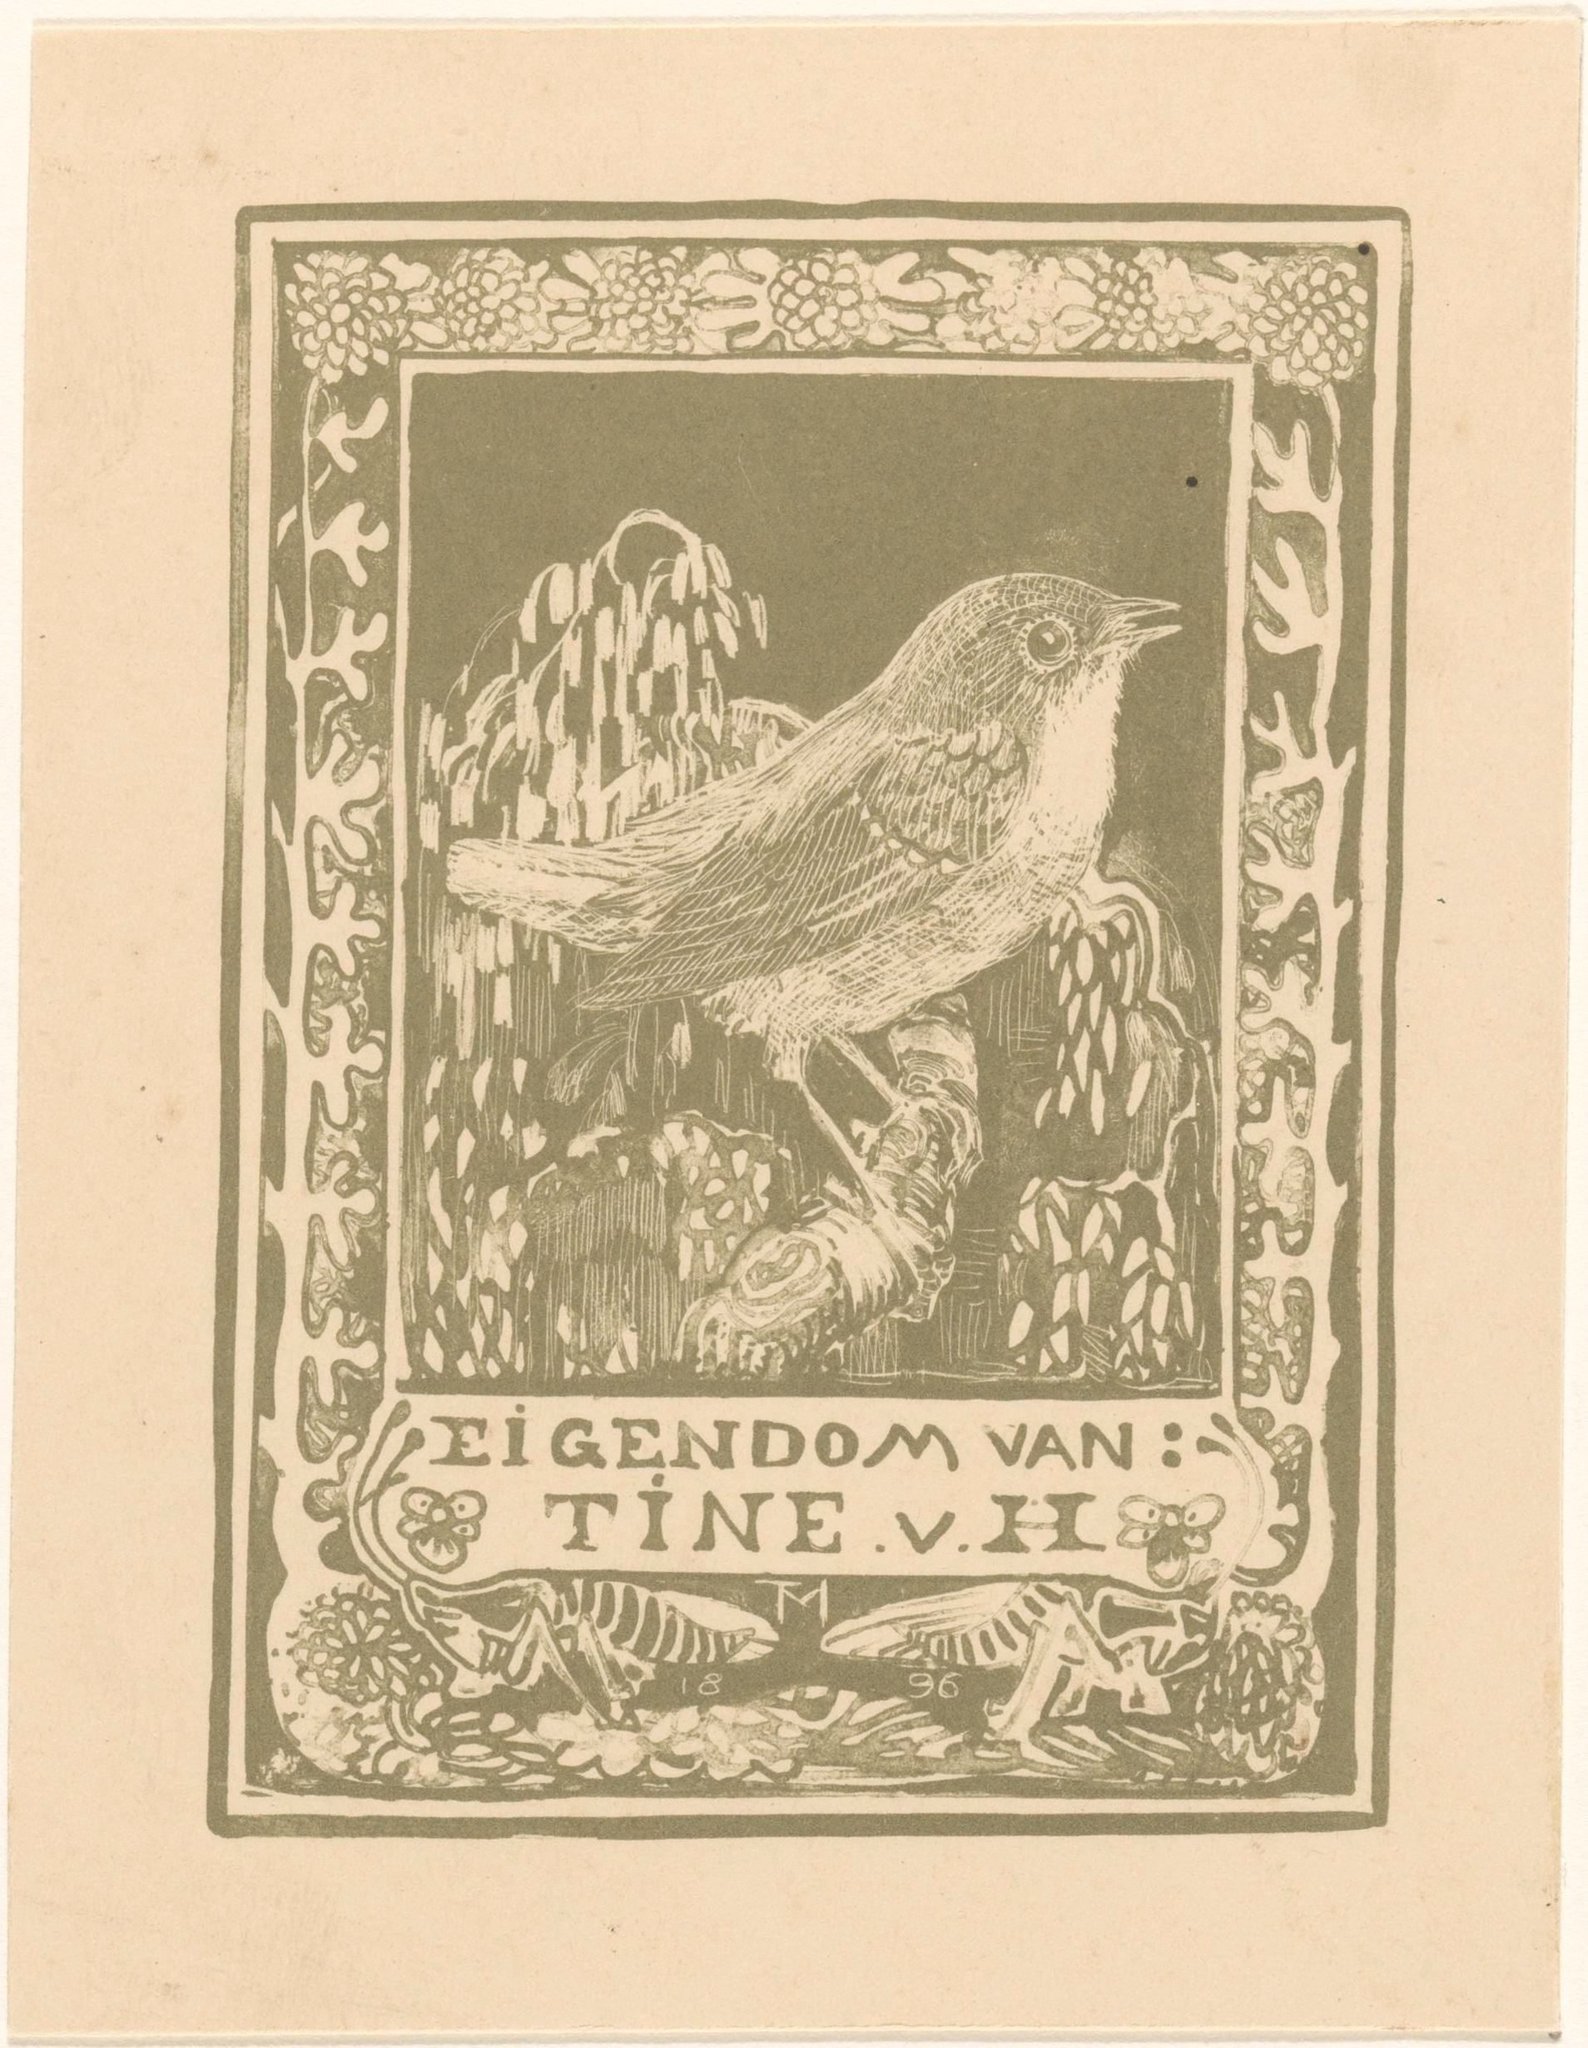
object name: bookplate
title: Ex libris van Tine van Hoytema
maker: theo van hoytema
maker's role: draughtsman, painter, print maker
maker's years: 1863-1917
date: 1896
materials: paper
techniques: lithograph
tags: song-birds: robin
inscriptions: collector's mark: Lugt 2233